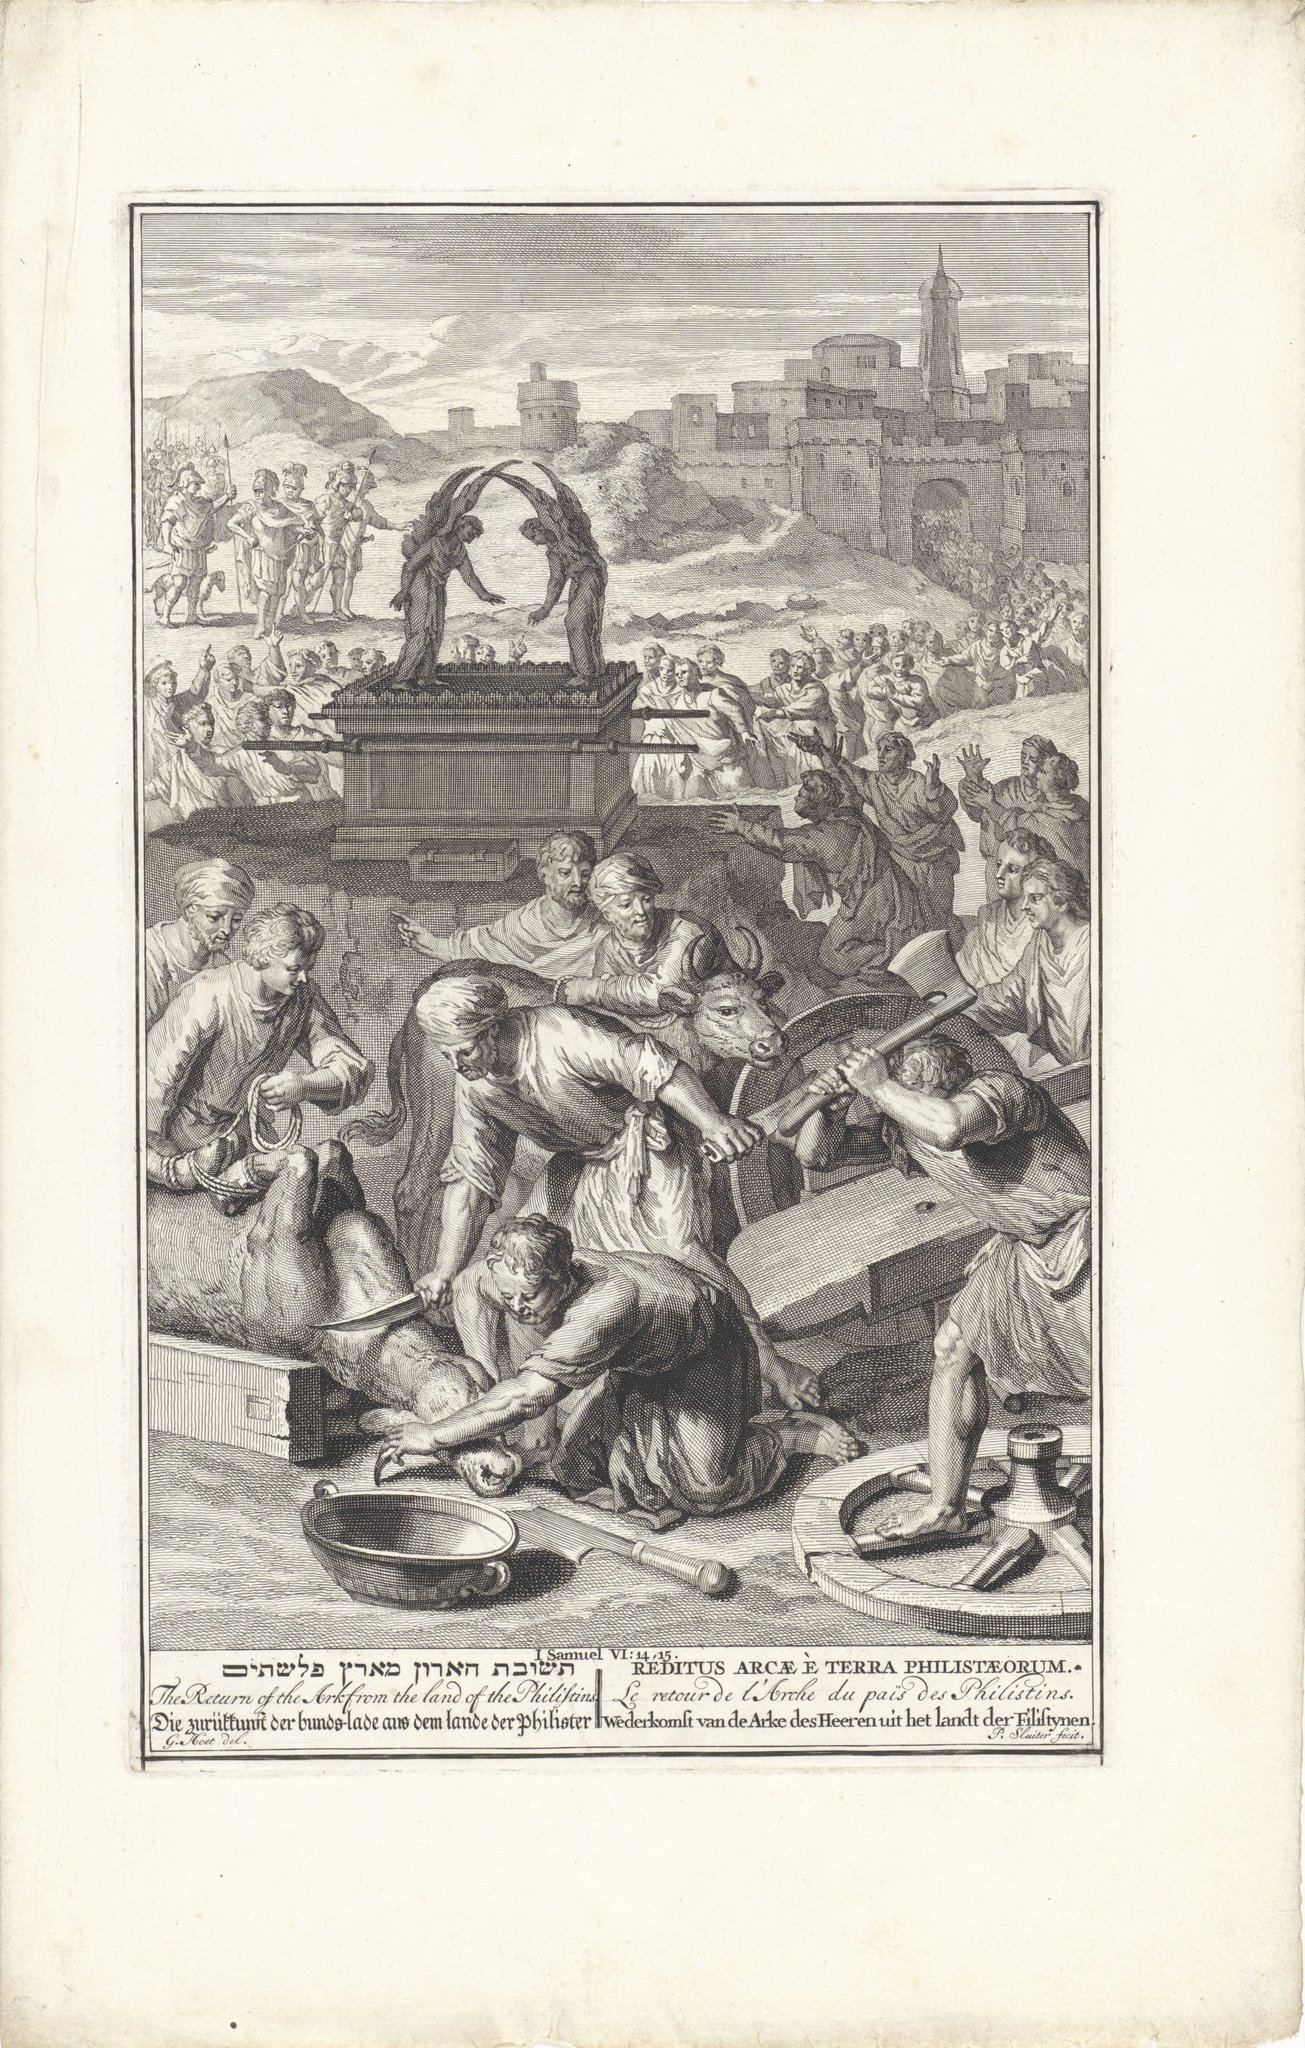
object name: print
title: Terugkomst van de ark des verbonds uit het land der Filistijnen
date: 1705-1720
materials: paper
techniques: engraving, etching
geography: amsterdam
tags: the ark of the covenant and the box with the guilt offering, drawn by two cows, sent back to israel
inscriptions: collector's mark: Lugt 2228, collector's mark: ‘Utrechts Fundatie huijs’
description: Het volk stroomt uit de stad ter verwelkoming van de ark des verbonds, die op een verhoging buiten de stad staat. Mannen staan op het punt een kalf te offeren. Een tweede kalf wordt naar de offerplaats geleid. Illustratie van de Bijbeltekst 1 Sam. 6: 14-15. Onder de voorstelling de titel in het Hebreeuws, Engels, Duits, Latijn, Frans en Nederlands.